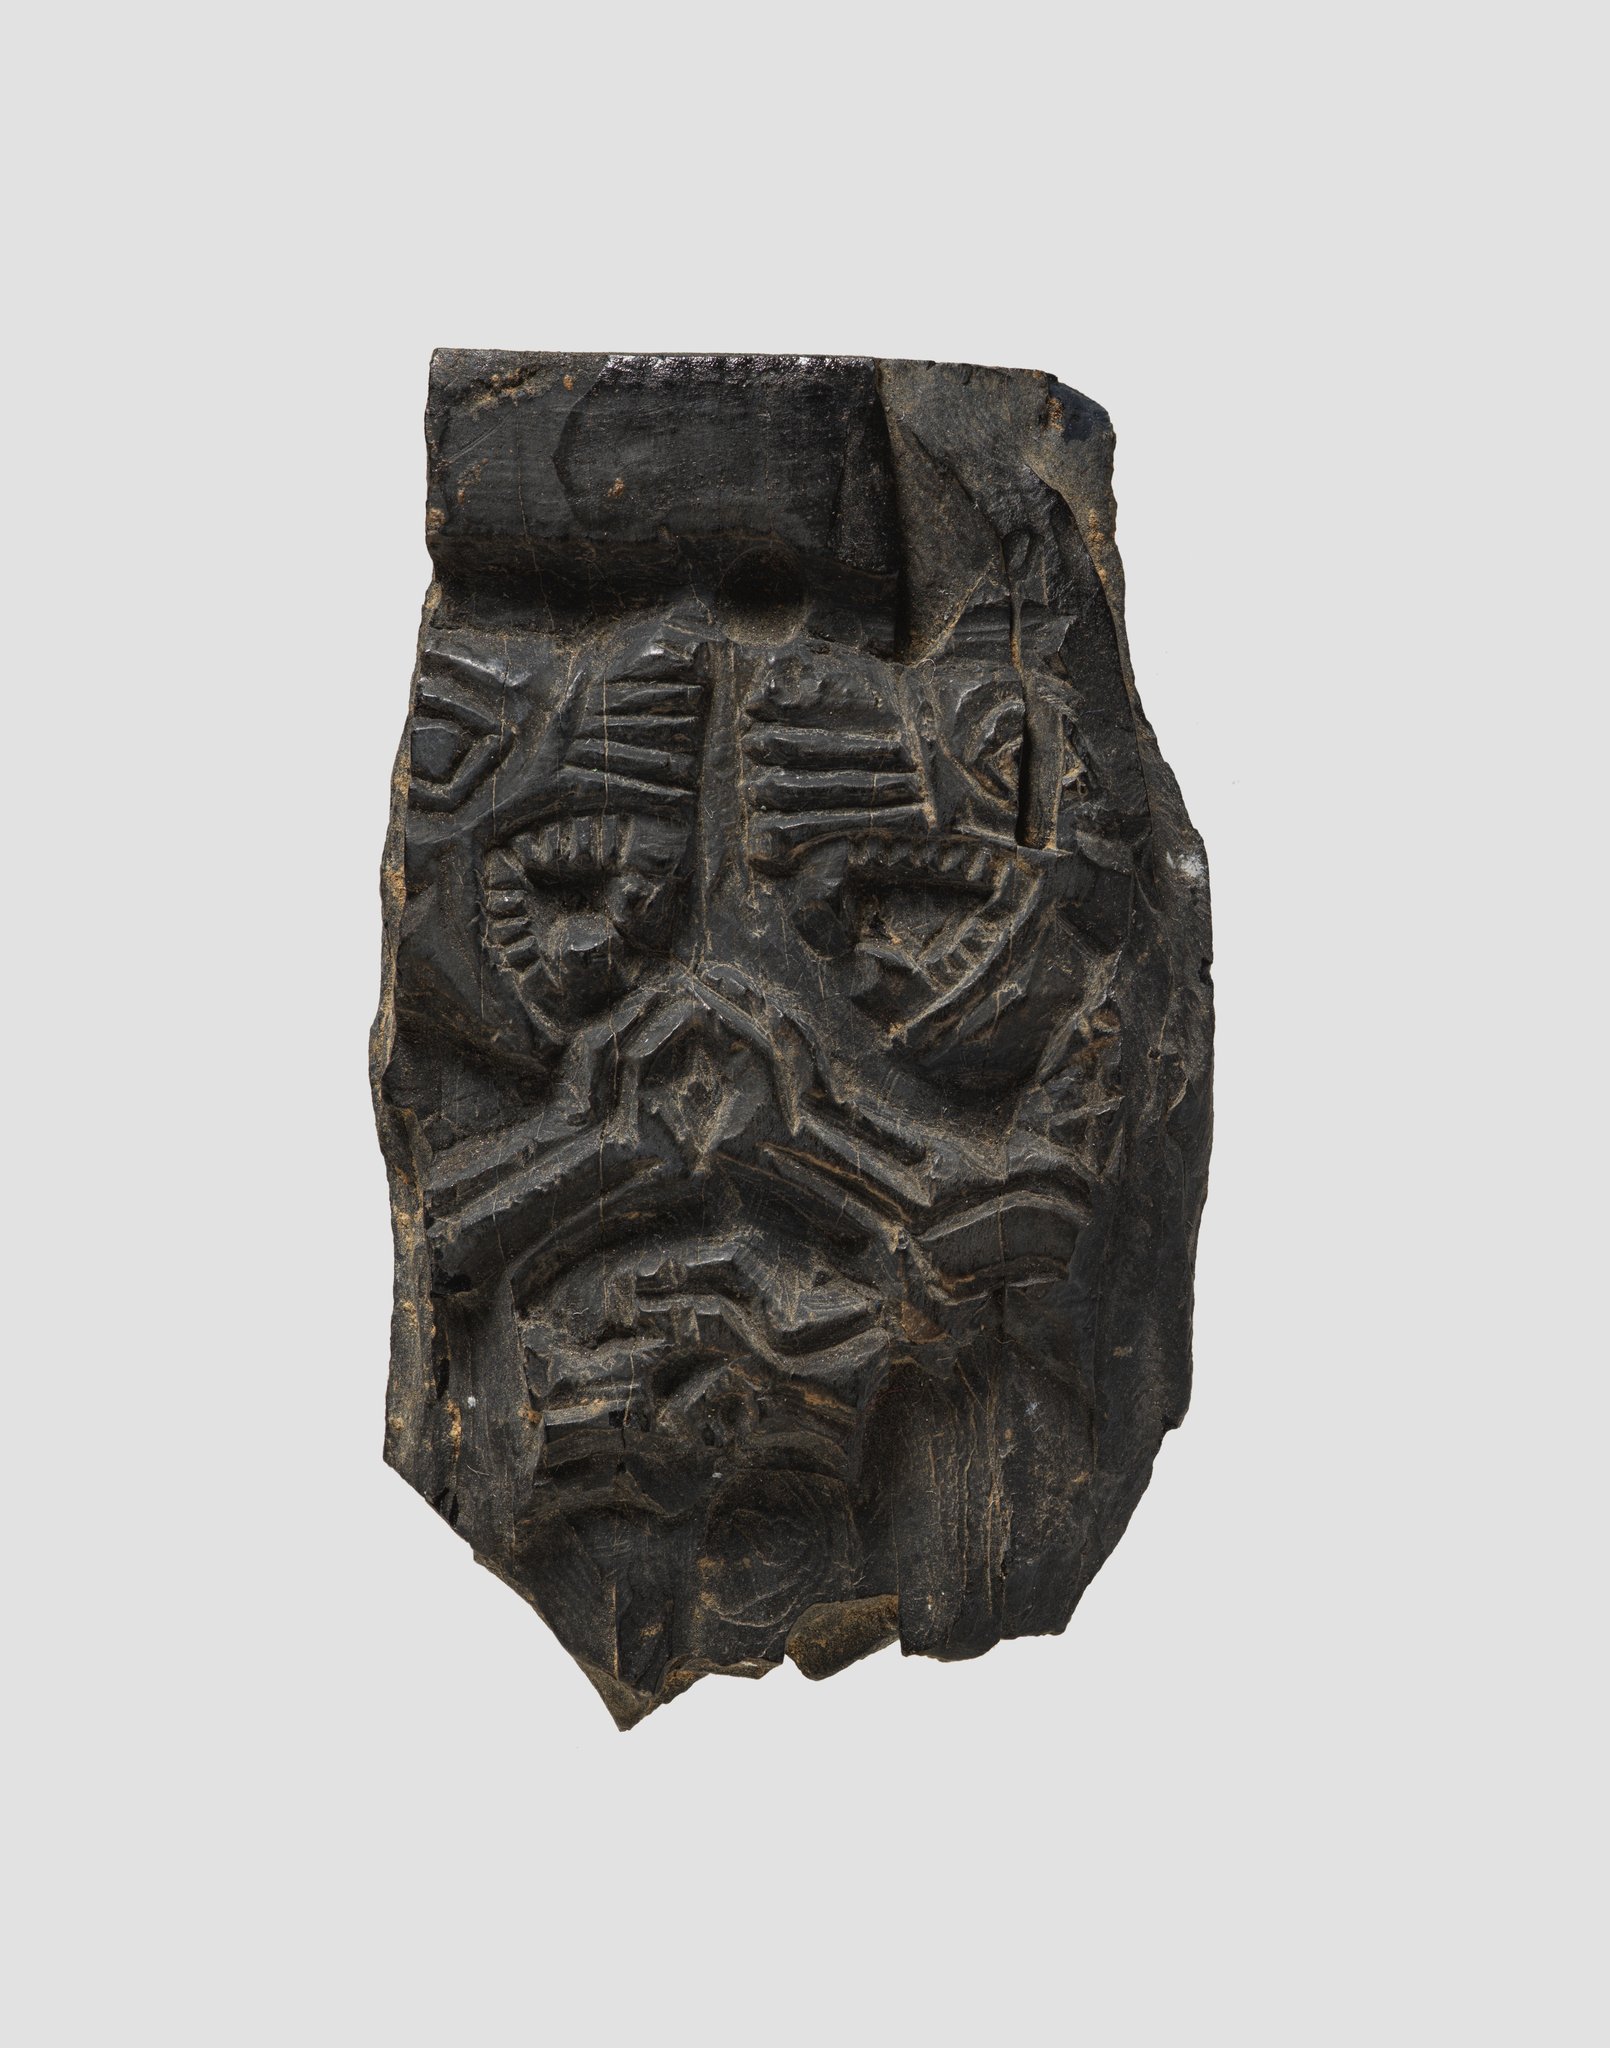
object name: relief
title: Plaque fragment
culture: iranian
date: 900-801 BCE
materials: ivory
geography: iran